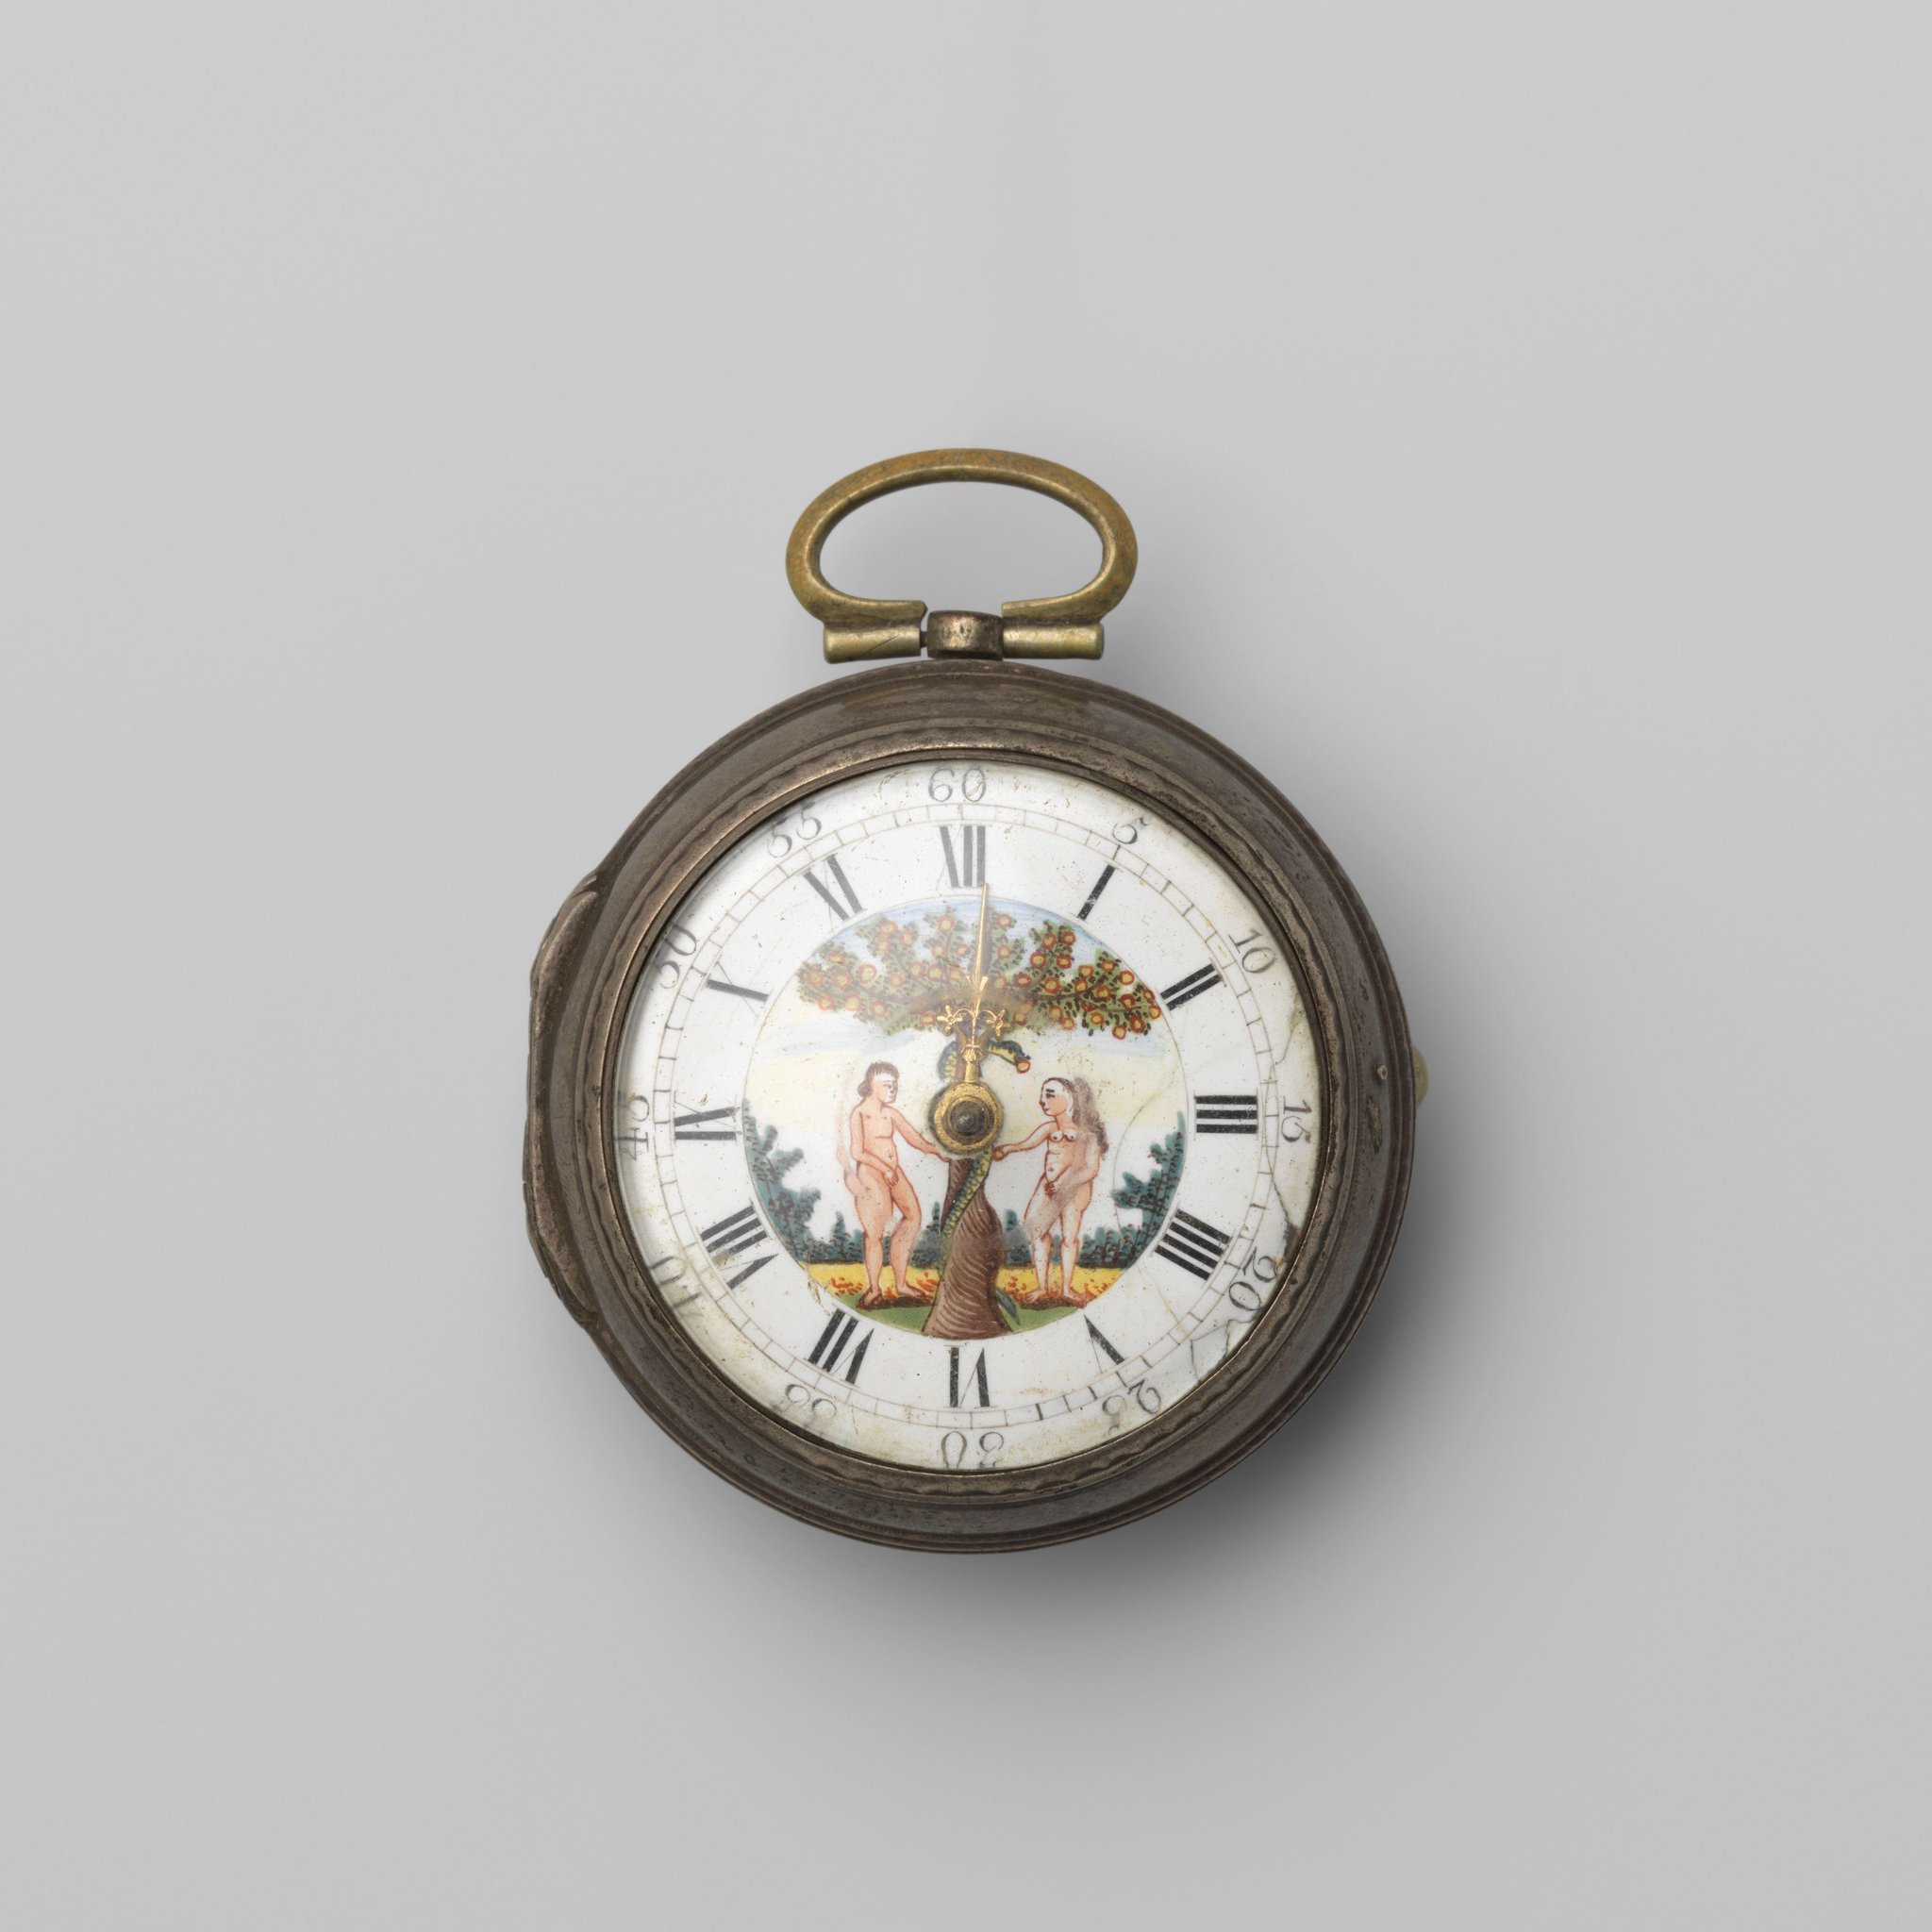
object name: wrist watch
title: Horloge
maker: wm. wood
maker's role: clockmaker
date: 1785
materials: silver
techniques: enameling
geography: london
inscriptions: mark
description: Horloge van zilver in losse, gladde kast. De witte, geëmailleerde wijzerplaat is voorzien van een email schildering, voorstellende Adam en Eva.